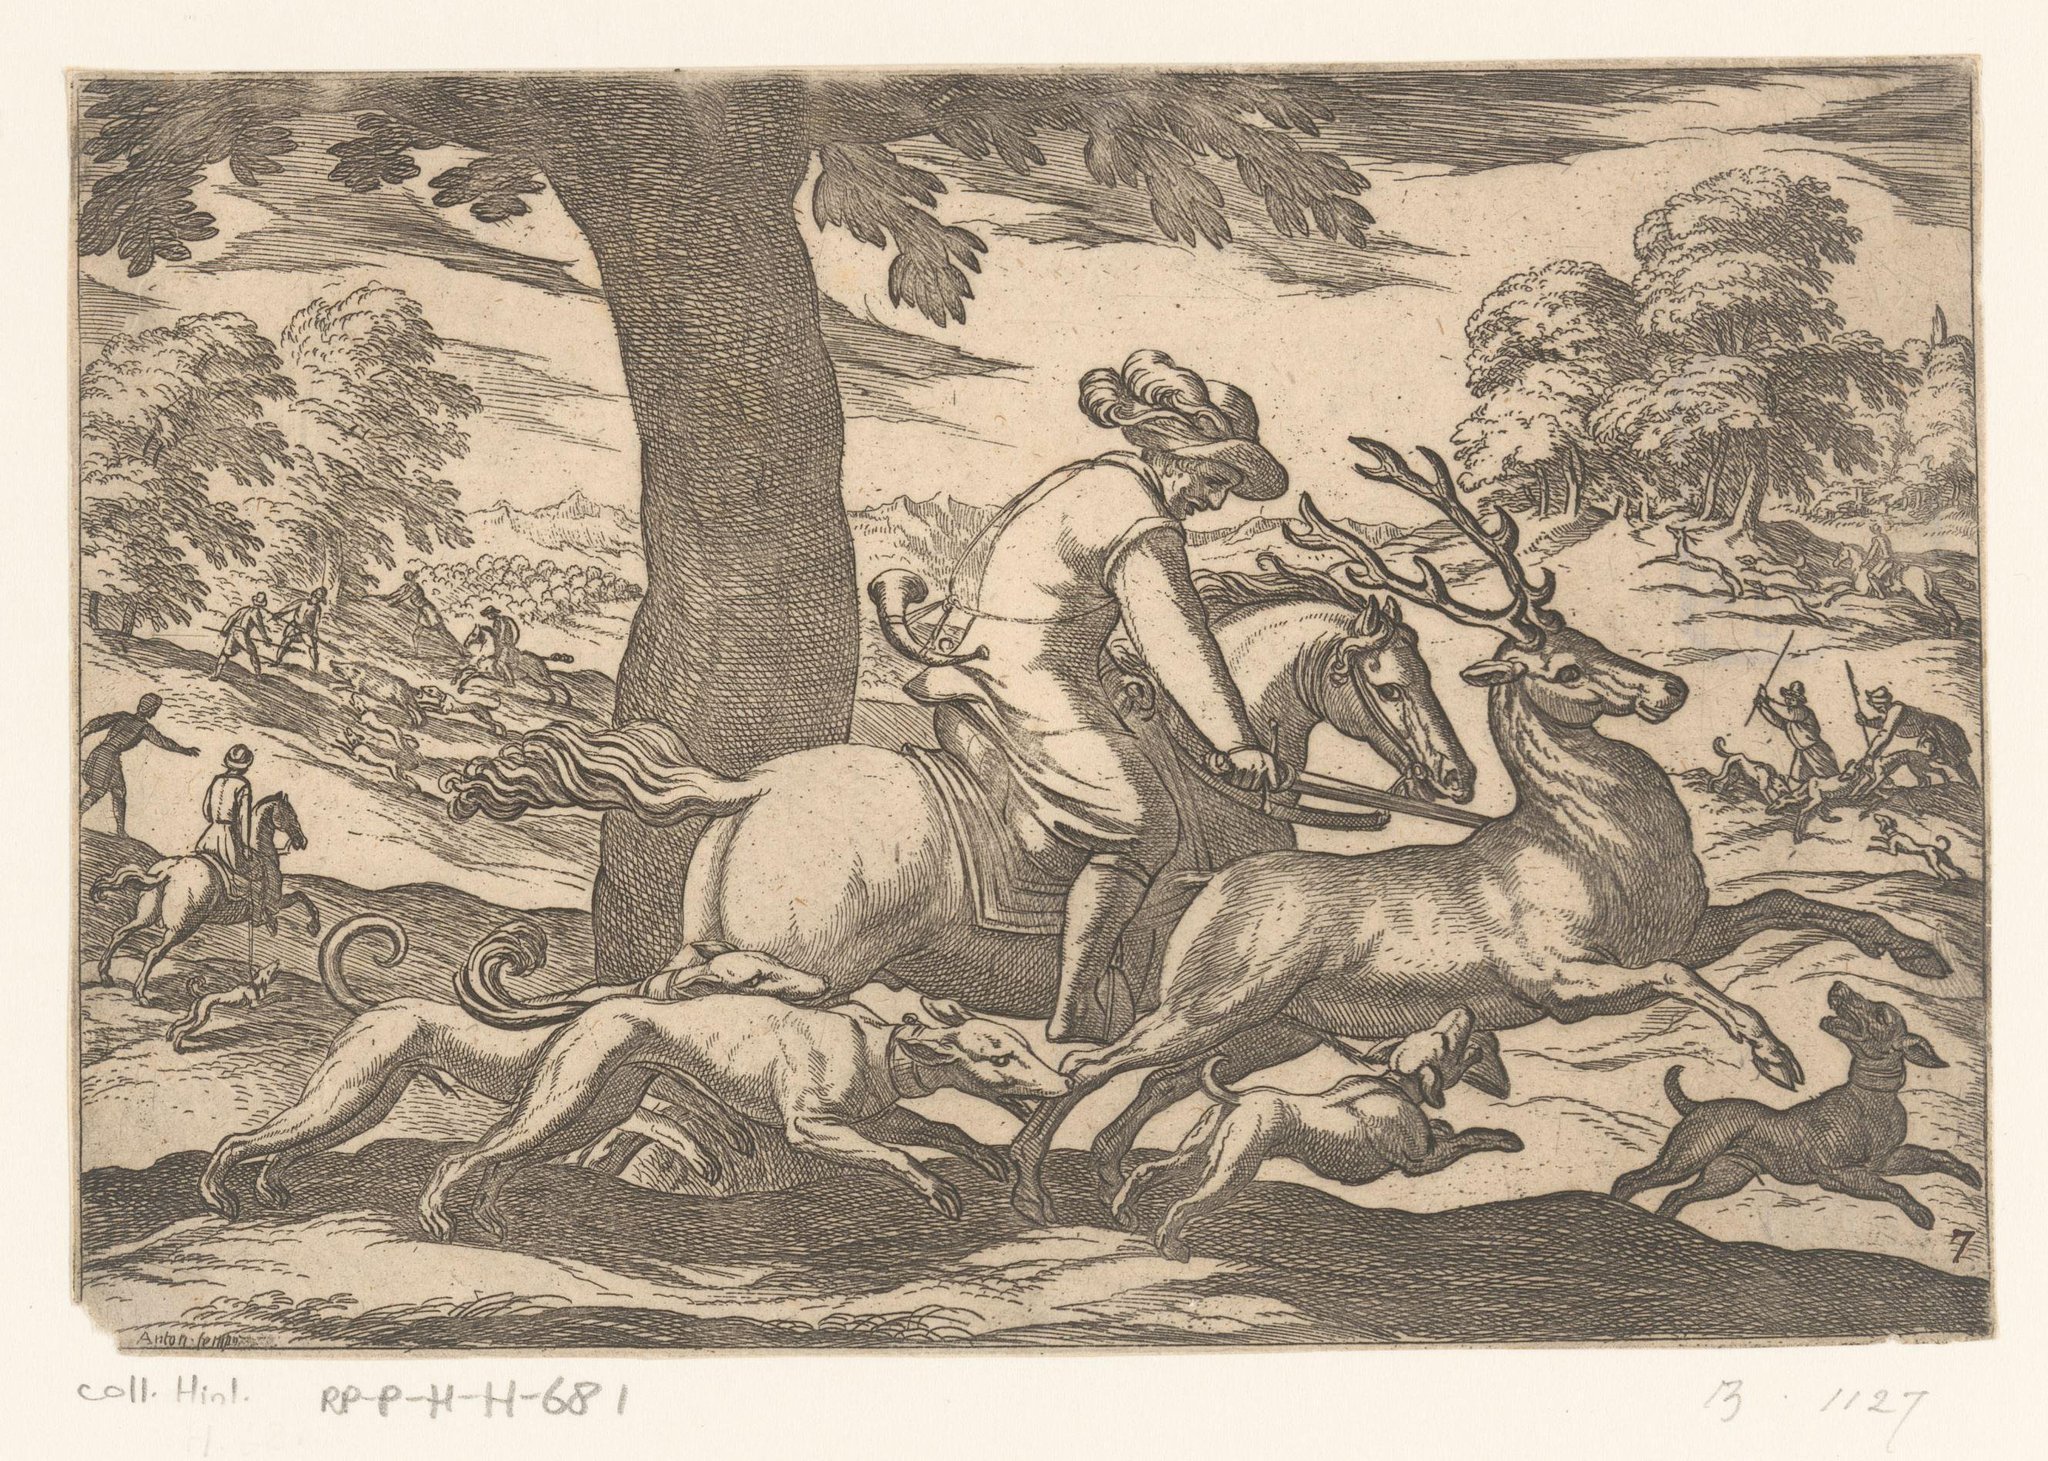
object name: print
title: Jachtscènes (deel 4)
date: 1595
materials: paper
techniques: etching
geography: italy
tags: stag-hunting, boar-hunting, hunter, hunters hunting (n.b.: in 1988-1990 this notation denoted the concept of 43c11421 'hunters resting during the hunt')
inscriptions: number: ‘7’, collector's mark: Lugt 11, collector's mark: ‘Hinloopen’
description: Landschap met jagers te paard jagend op herten. Op de achtergrond links wordt er gejaagd op everzwijnen.